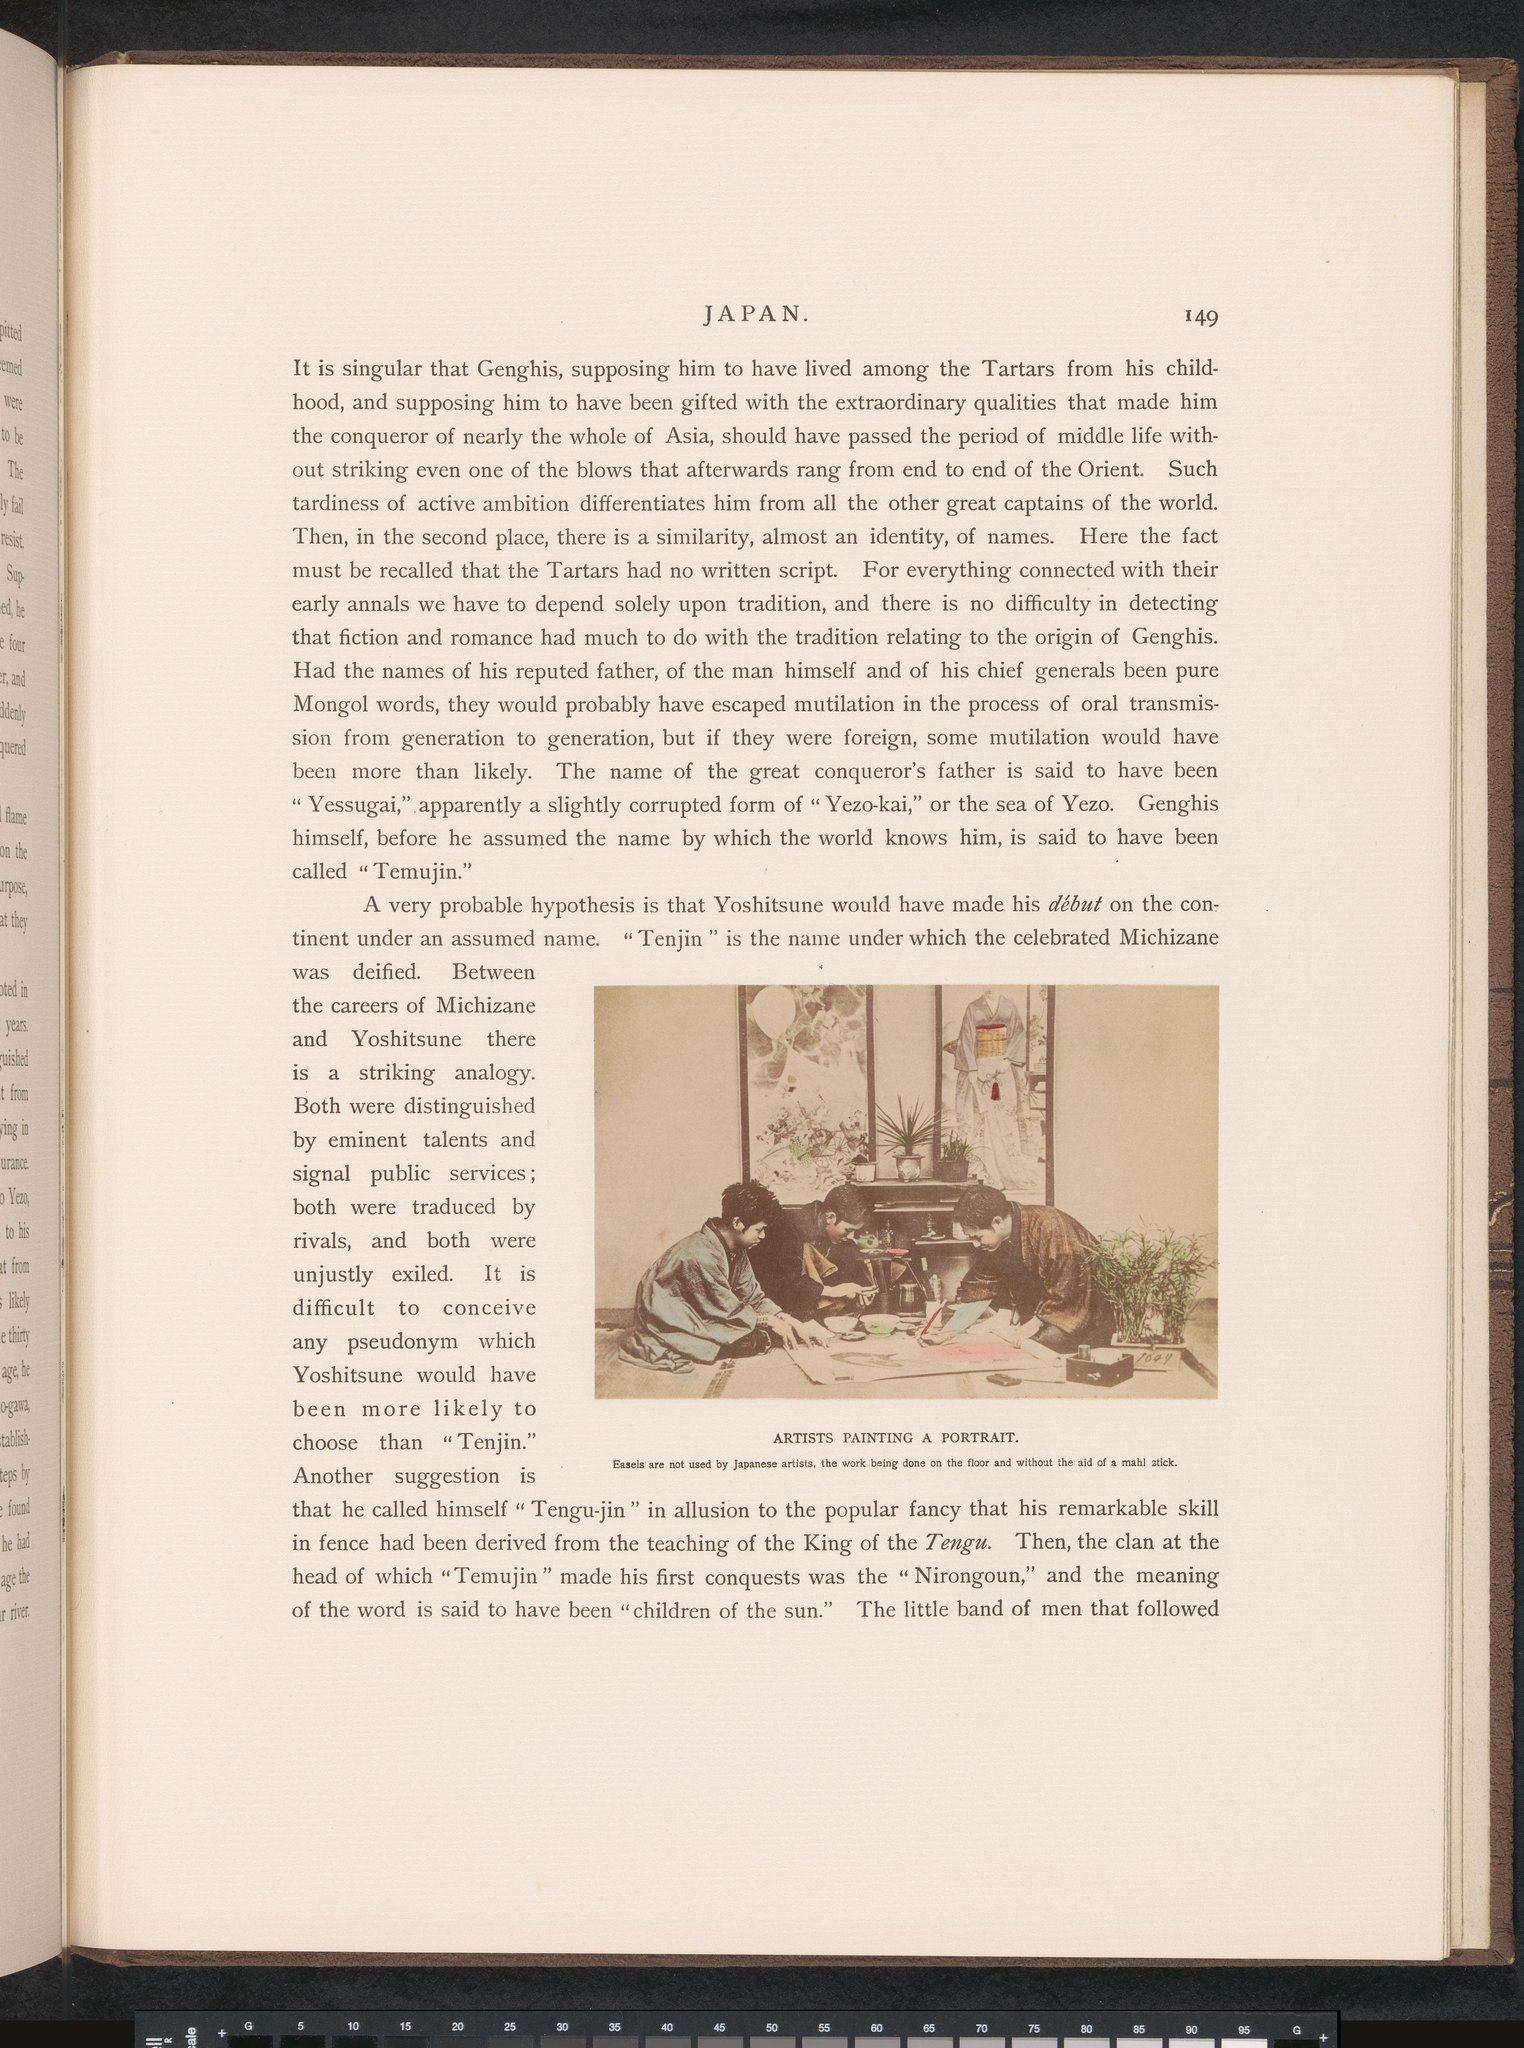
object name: page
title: Artists painting a portrait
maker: Anonymous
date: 1887-1897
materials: photographic support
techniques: albumen print, hand coloring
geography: japan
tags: artist at work, in his workshop, interior ~ representation of a building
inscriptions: inscription: ‘Easles are not used by Japanese artists, the work being done on the floor and without the aid of a mahl stick.’